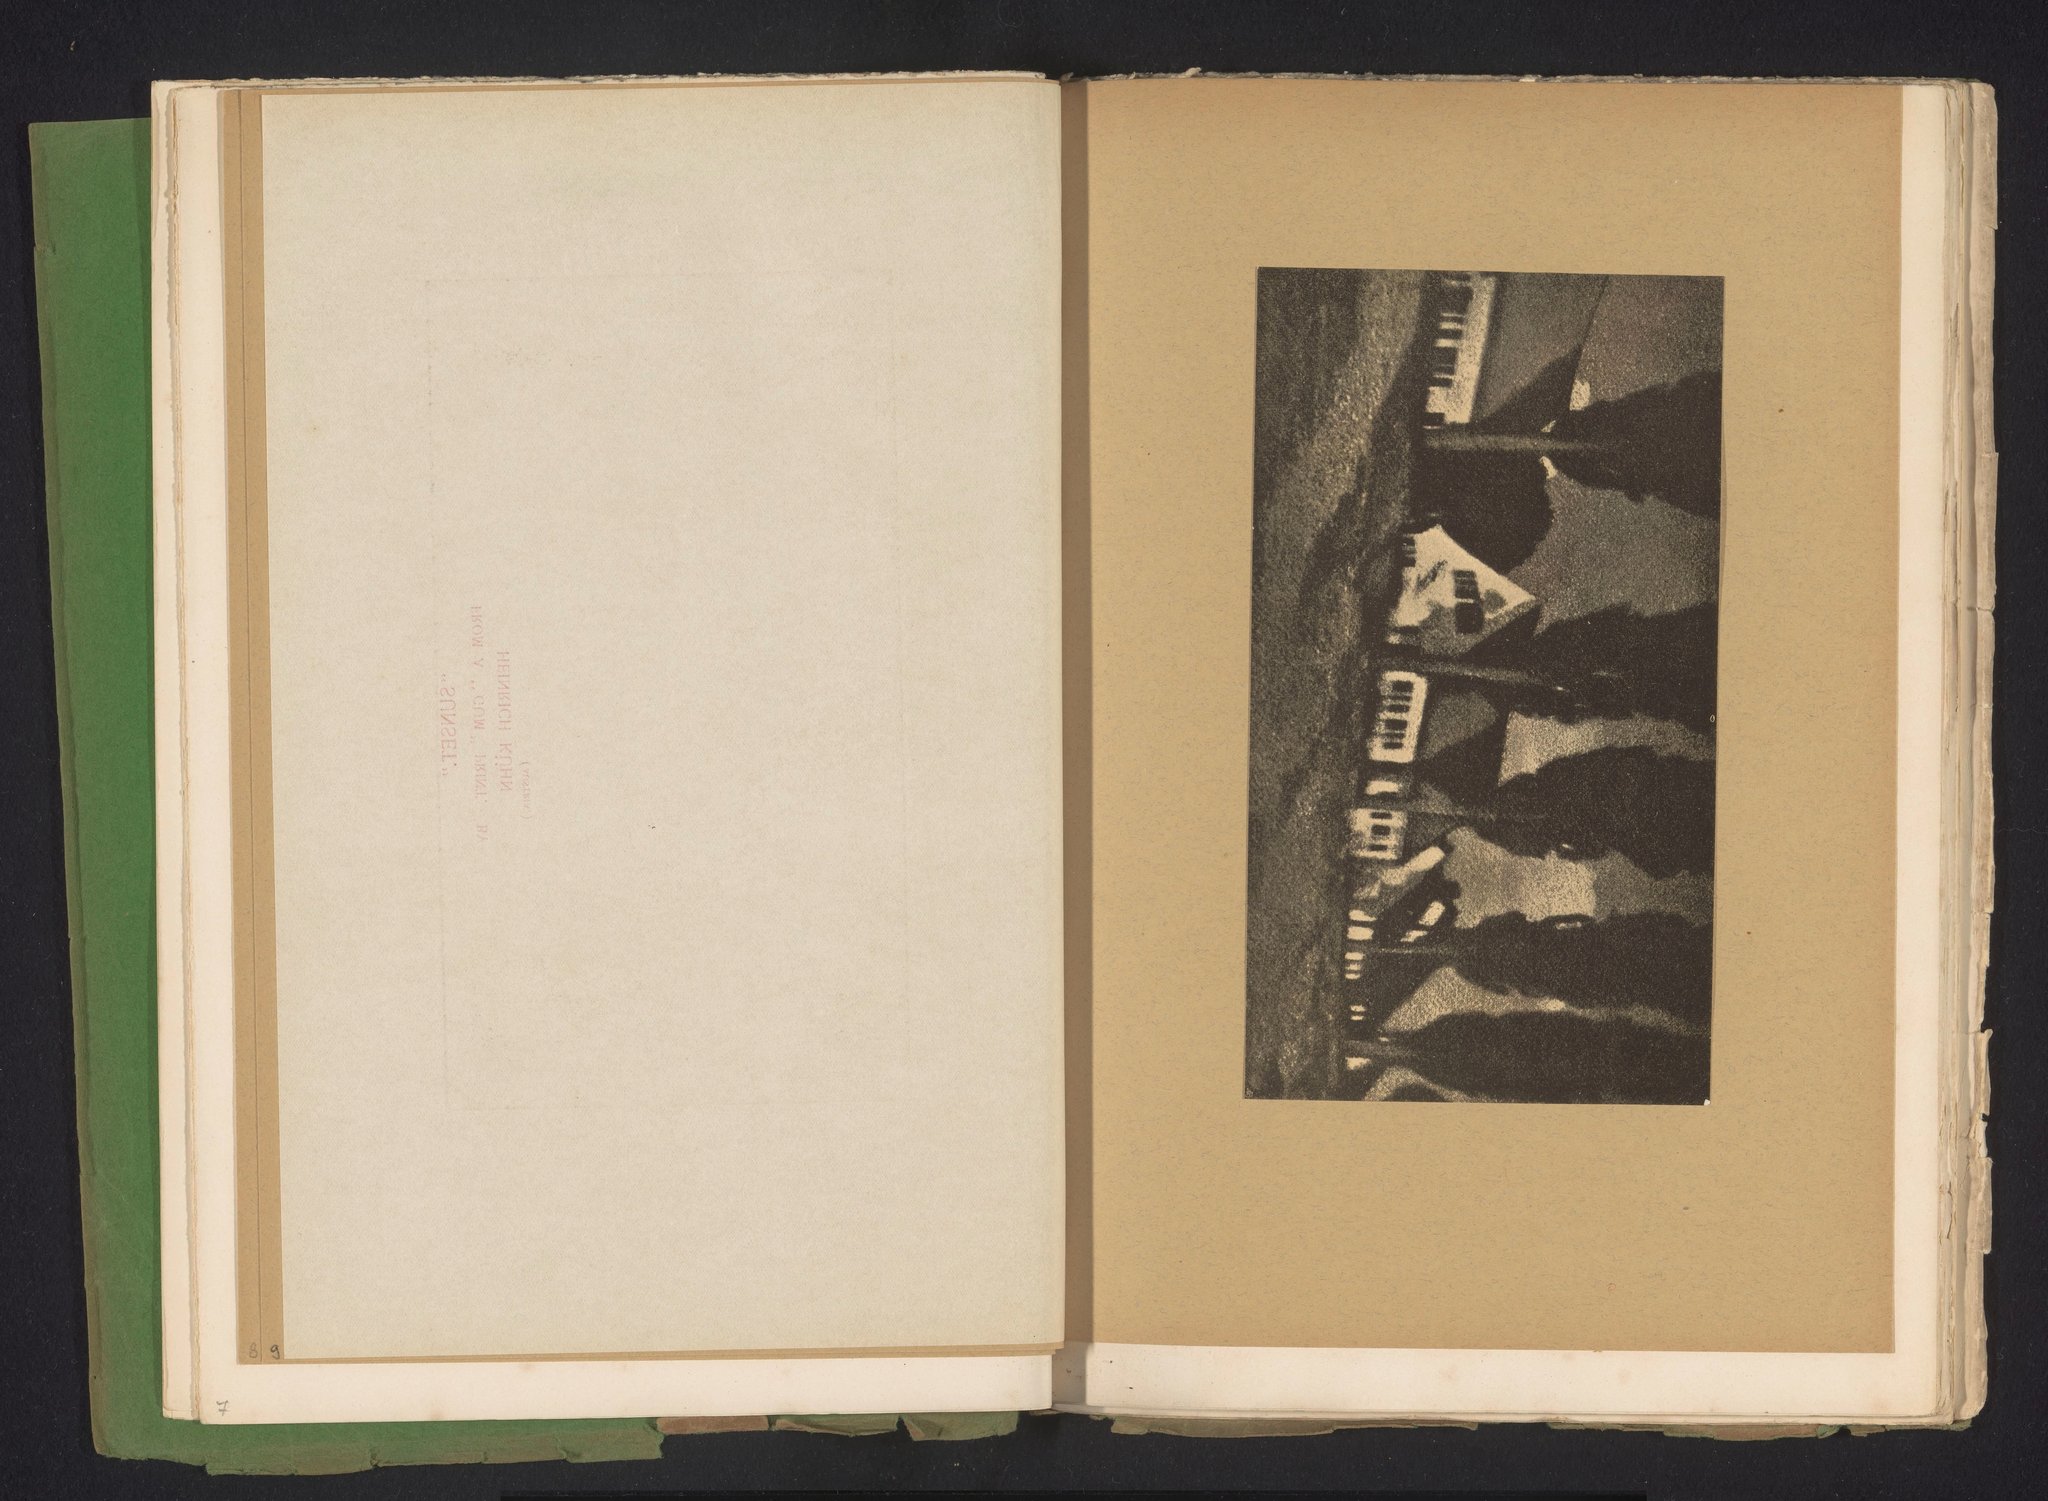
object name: page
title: Sunset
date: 1897-1902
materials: paper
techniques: autotype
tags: trees, country-house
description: Prent op vijfde ongenummerde pagina na pagina 250, achter semi-transparante omslag.